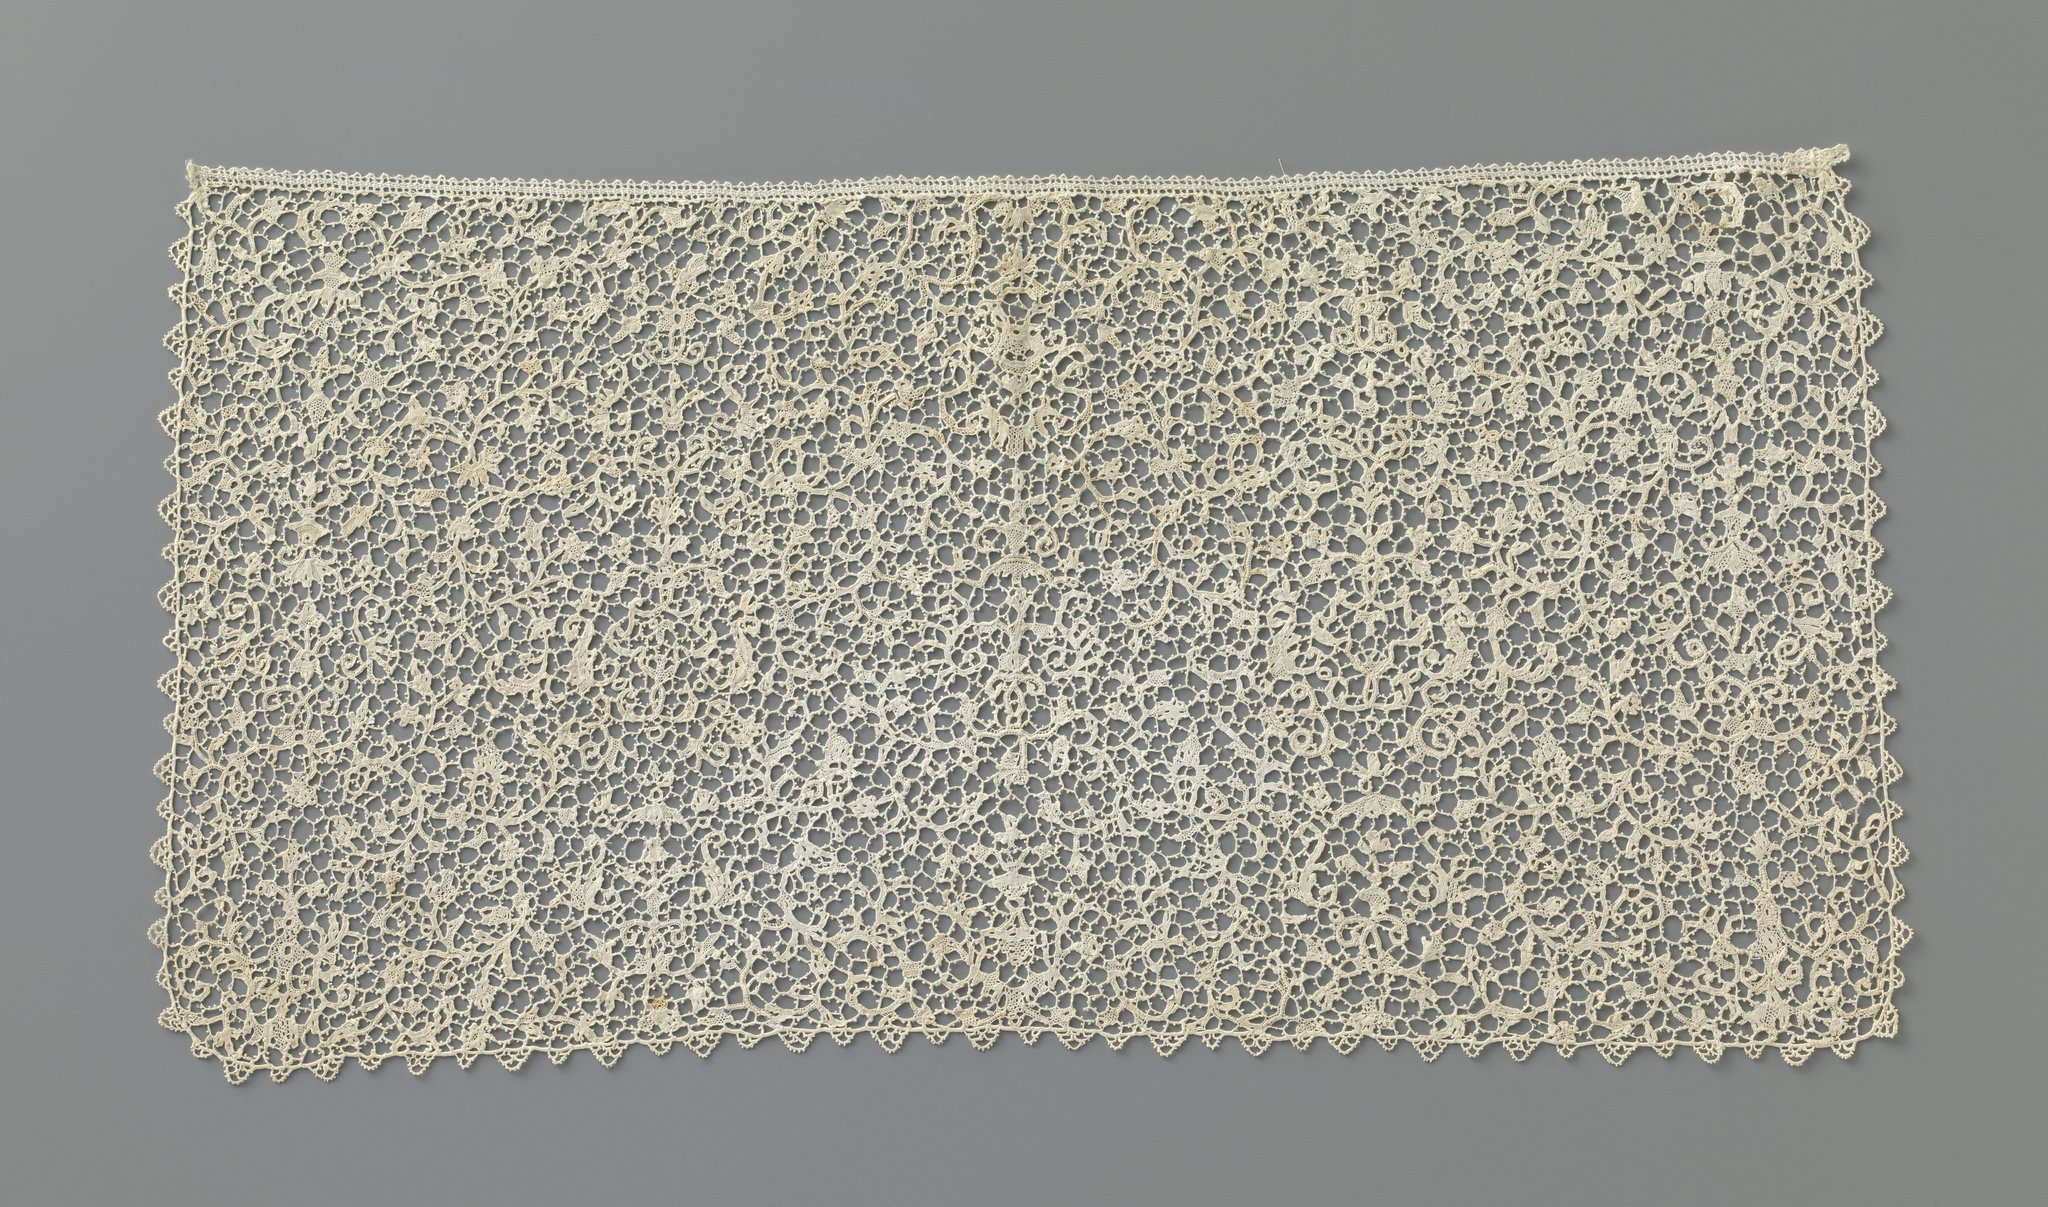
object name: dasslip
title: Dasslip van naaldkant met candelabre-motieven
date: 1690-1709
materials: linen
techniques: flat venetian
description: Dasslip van naturelkleurige naaldkant: platte Venetiaanse kant of point de France. Op een grove zeshoekige maasgrond staat een decor van vijf symmetrische en zeer ijle candelabre-motieven, die verbonden worden door vertakte spiraalranken, waaraan miniatuur palmetbloemen en knoppen staan. Aan drie zijden afgewerkt met afwisselend grote en kleine driehoekige bogen.